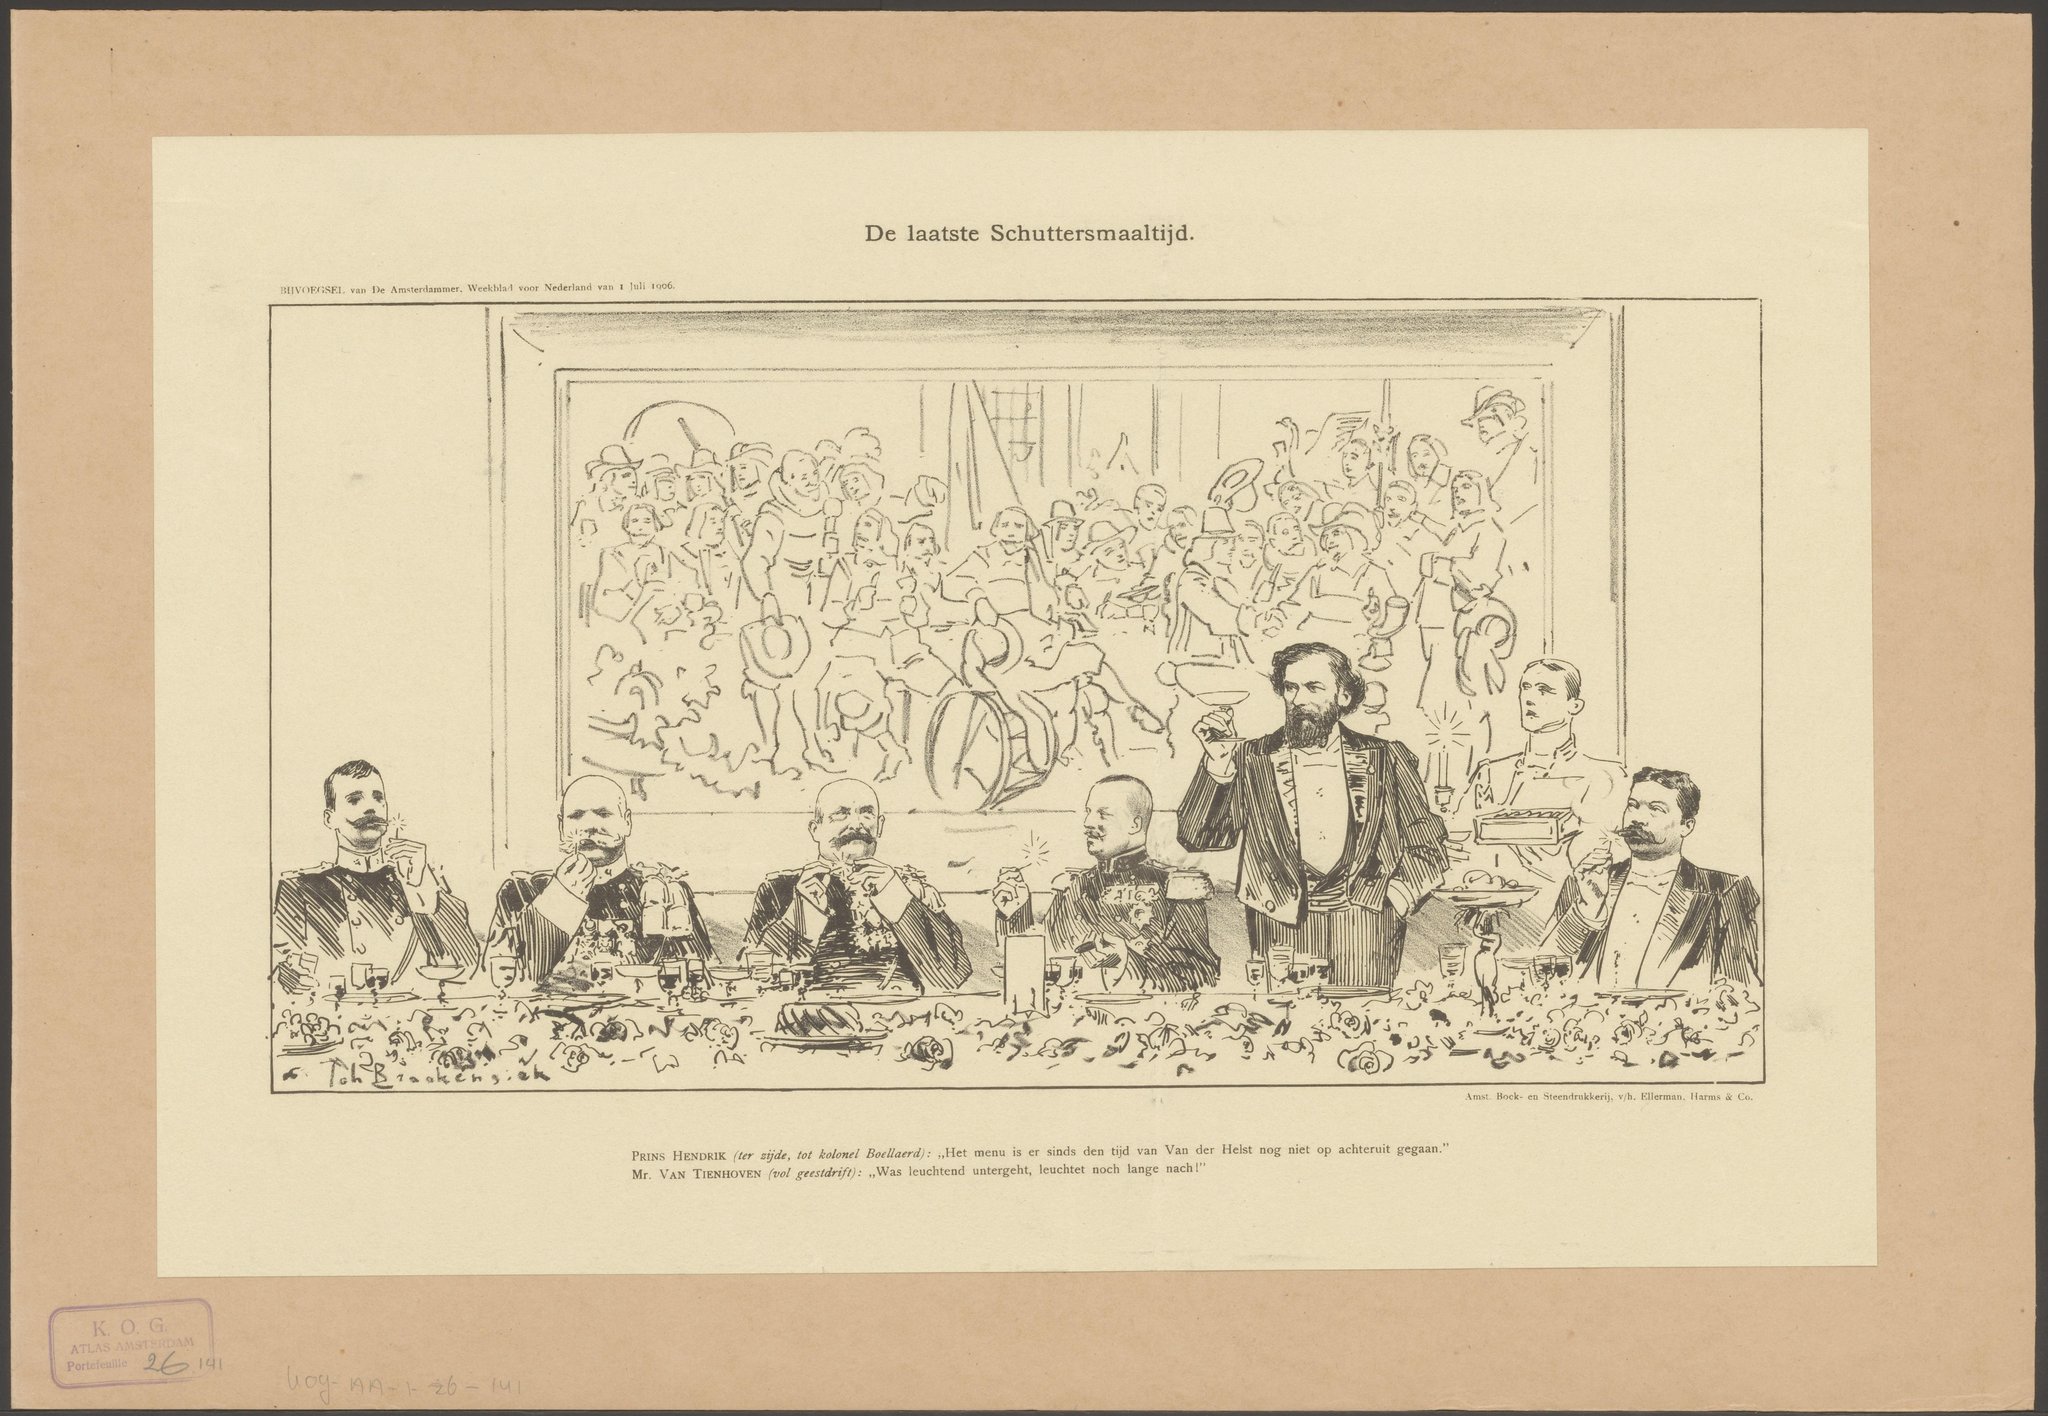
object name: cartoon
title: De laatste Schuttersmaaltijd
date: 1906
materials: paper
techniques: letterpress printing, lithograph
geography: amsterdam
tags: politician, the hague, hendrik (prins der nederlanden (1876-1934)), gijsbert van tienhoven, celebration meal, feast, banquet, picture, painting, political caricatures and satires, amsterdam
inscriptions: collector's mark: Lugt 1641b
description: Commissaris van de Koningin in Noord-Holland Gijsbert van Tienhoven richt een banket aan voor prins Hendrik, Jan Willem Boellaard tot Herwijnen en andere gasten. Van Tienhoven brengt staande een toost uit, met op de achtergrond de Schuttersmaaltijd door Bartholomeus van der Helst. Onderwerpsrubriek binnen de Atlas Amsterdam: Herinneringen aan de Schutterij.